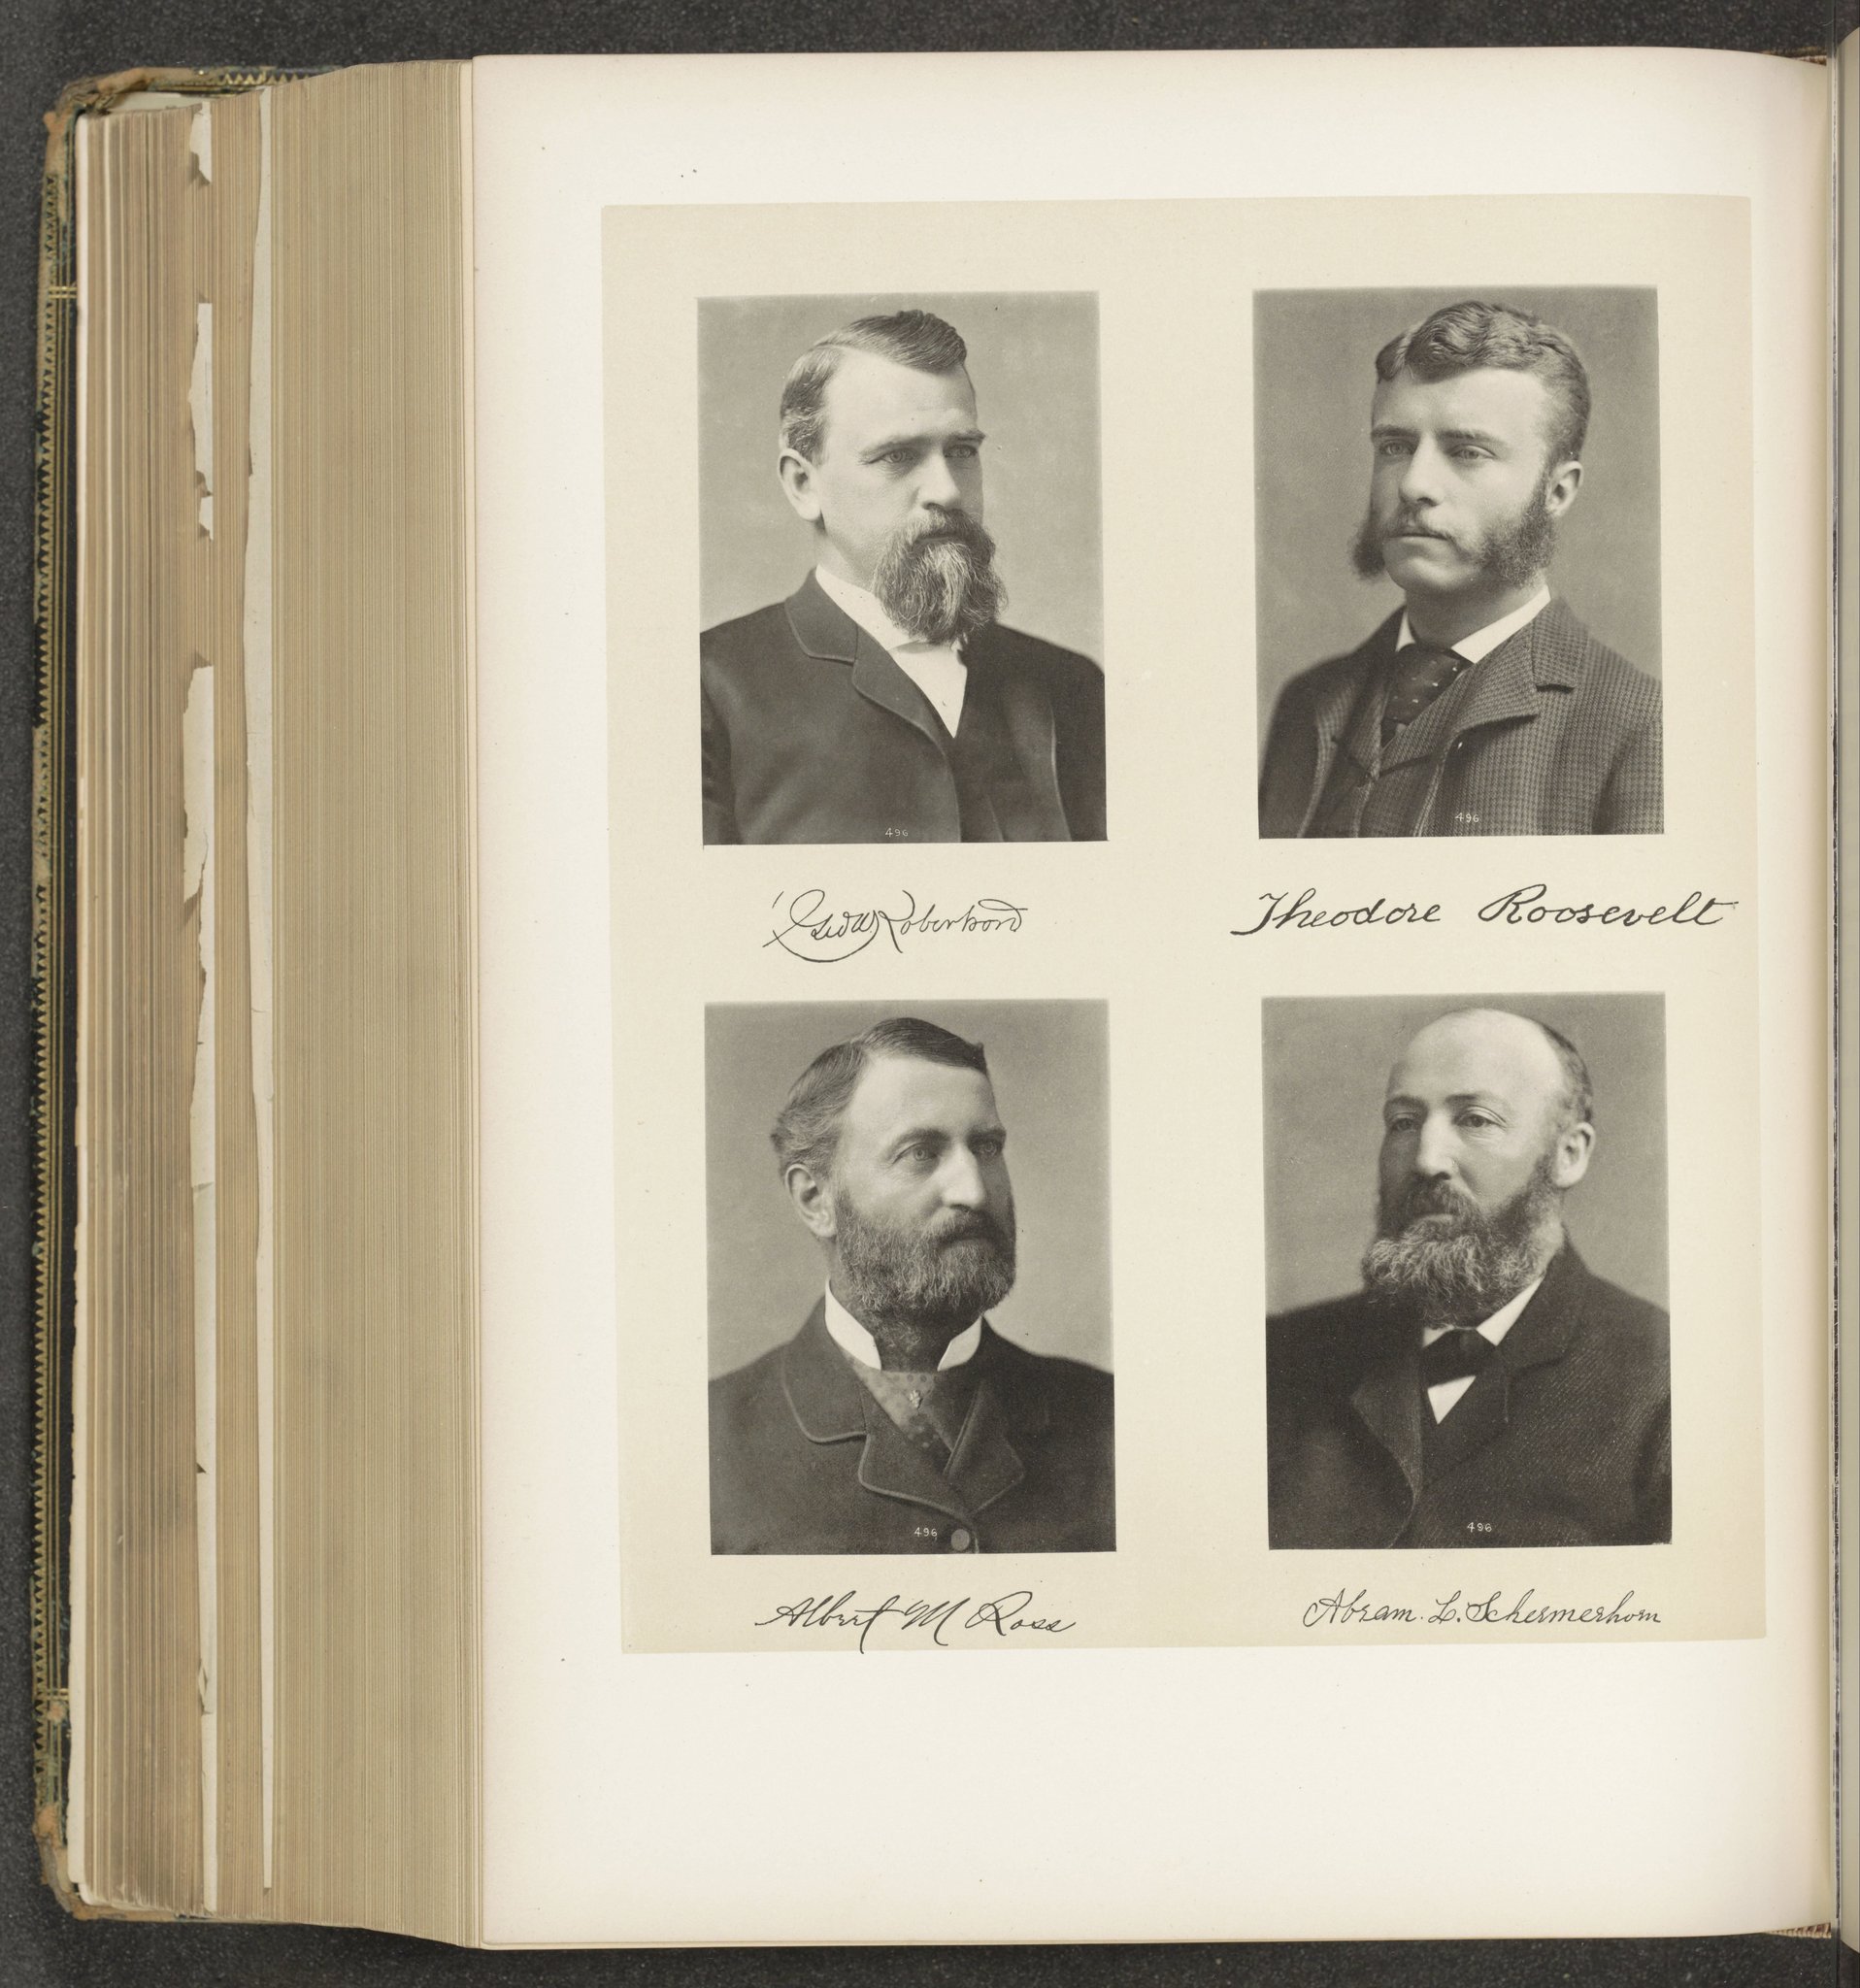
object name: page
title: Portretten van vier leden van het Lagerhuis van de staat New York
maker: Anonymous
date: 1872-1882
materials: paper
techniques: photograph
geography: united states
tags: new york (city), politician, historical persons (portraits and scenes from the life) (+ head (and shoulders) (portrait))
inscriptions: annotation, number: ‘496’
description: Linksboven George W. Robertson, rechtsboven Theodore Roosevelt, linksonder Albert M. Ross, rechtsonder Abram L. Schermerhorn.